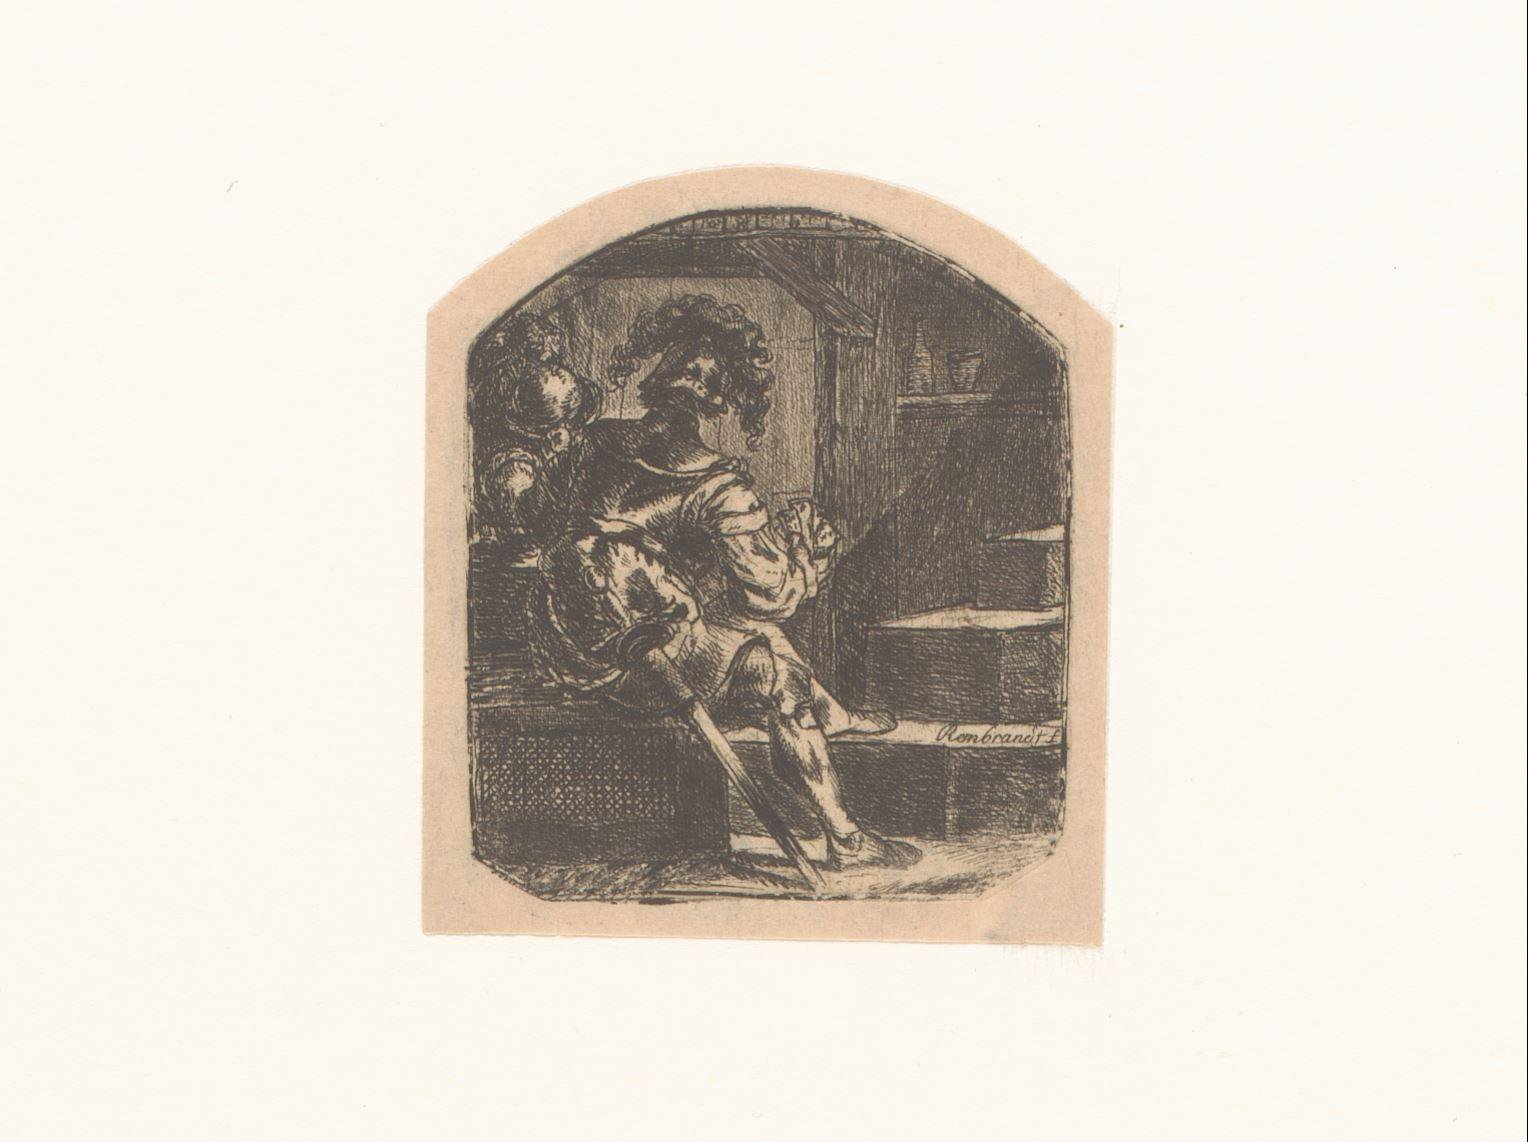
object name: print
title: Twee geharnaste soldaten spelen een kaartspel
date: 1778-1781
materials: paper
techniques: drypoint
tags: card games, guard duty, keeping sentry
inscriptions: collector's mark: Lugt 2228